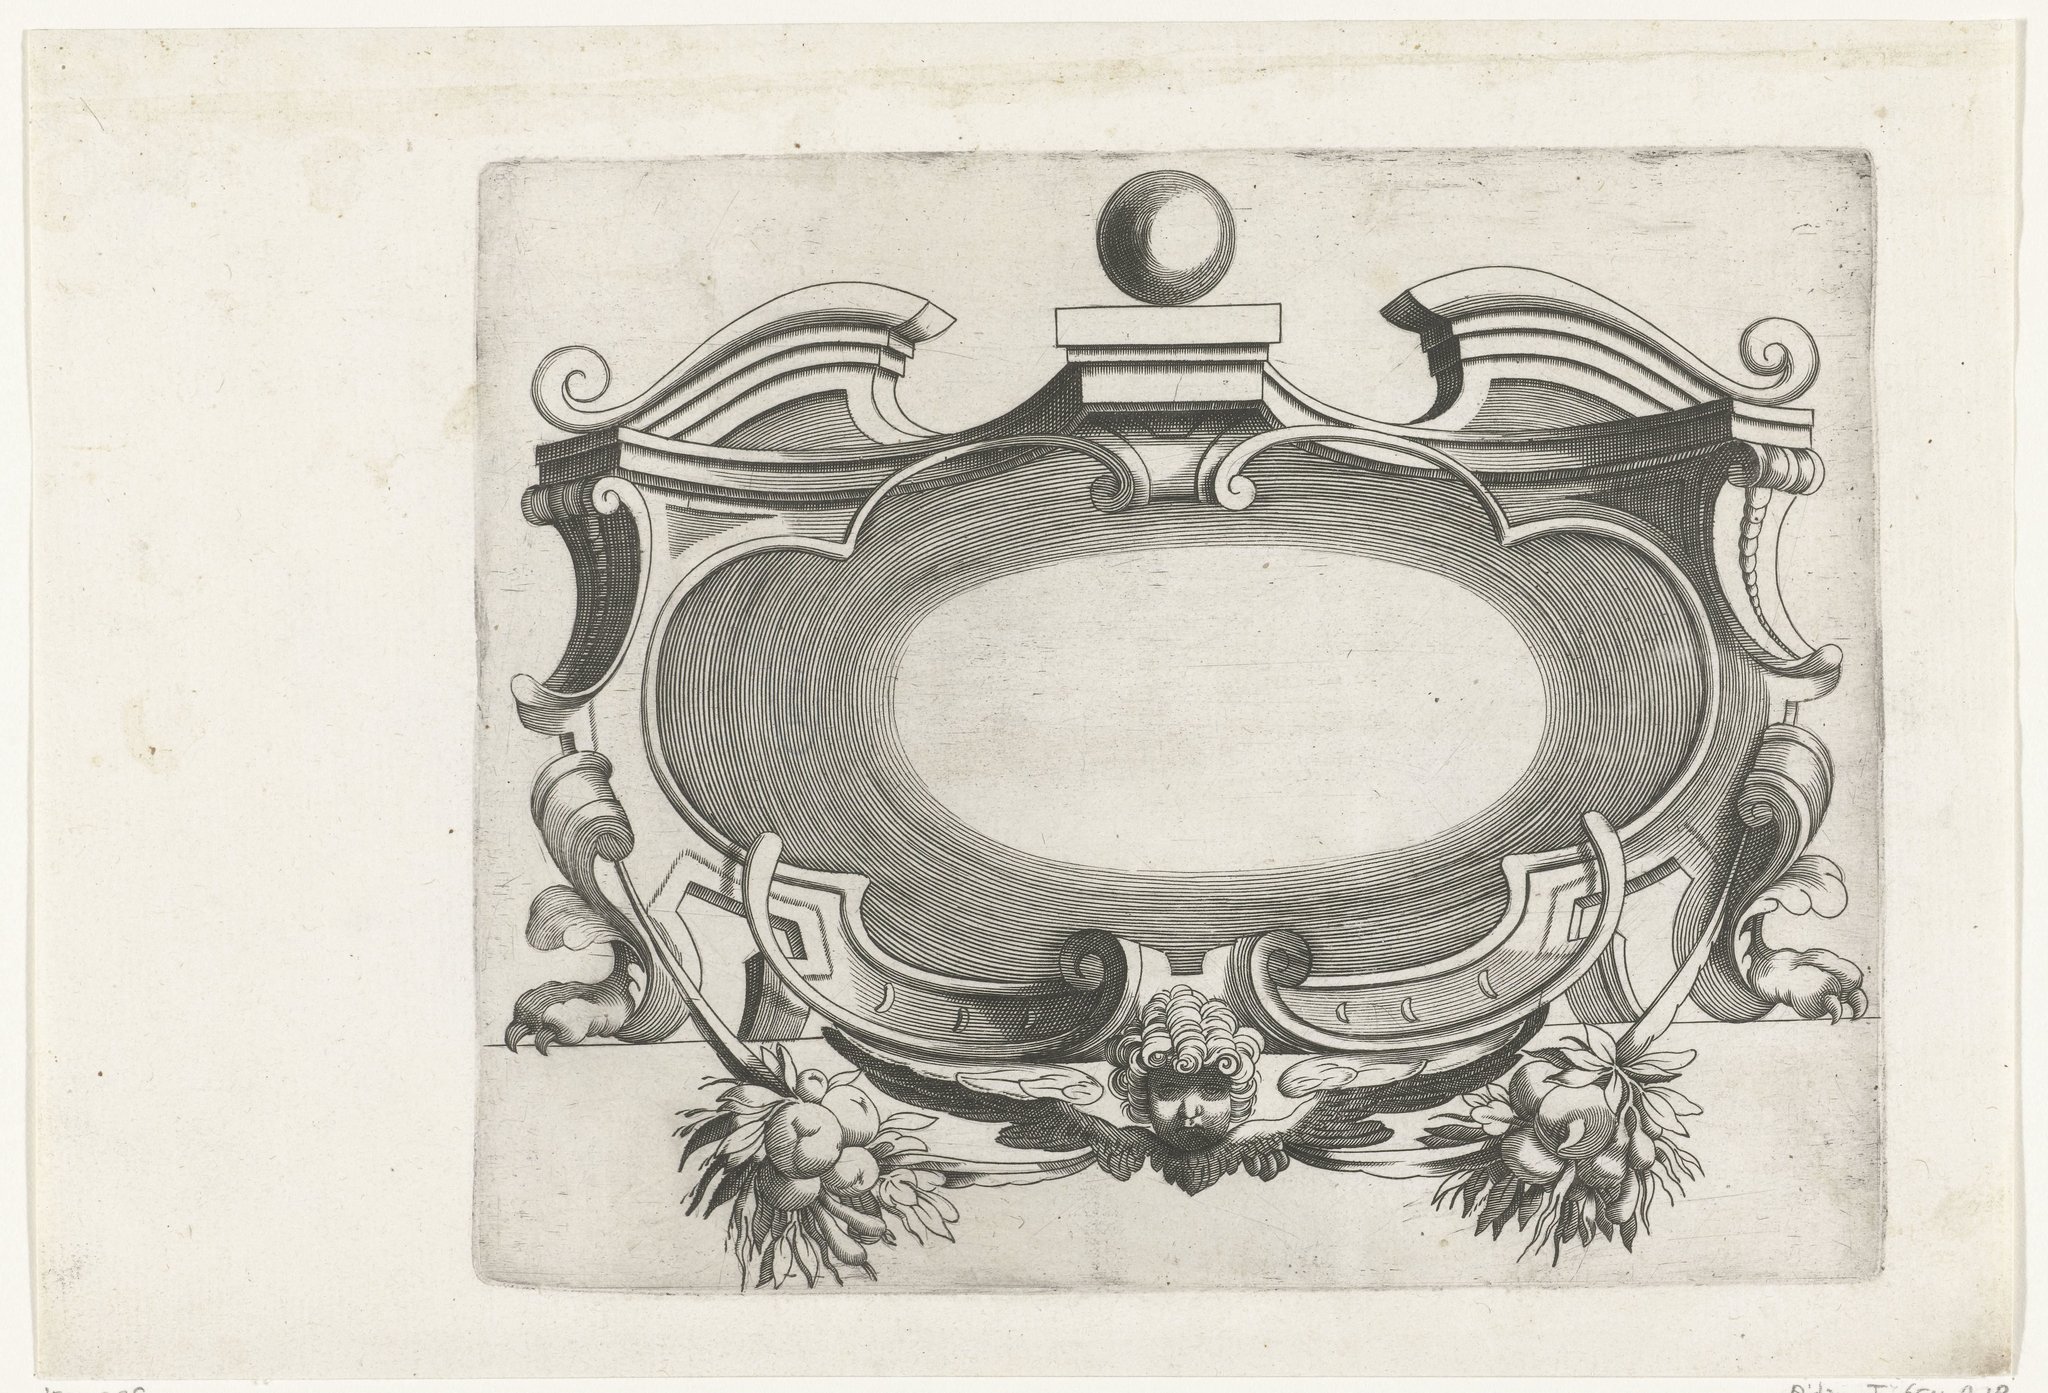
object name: ornament print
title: Cartouche in de vorm van gebroken fronton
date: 1628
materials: paper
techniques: engraving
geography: france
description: Midden onder hangt een cherubijntje tussen trossen vruchten.